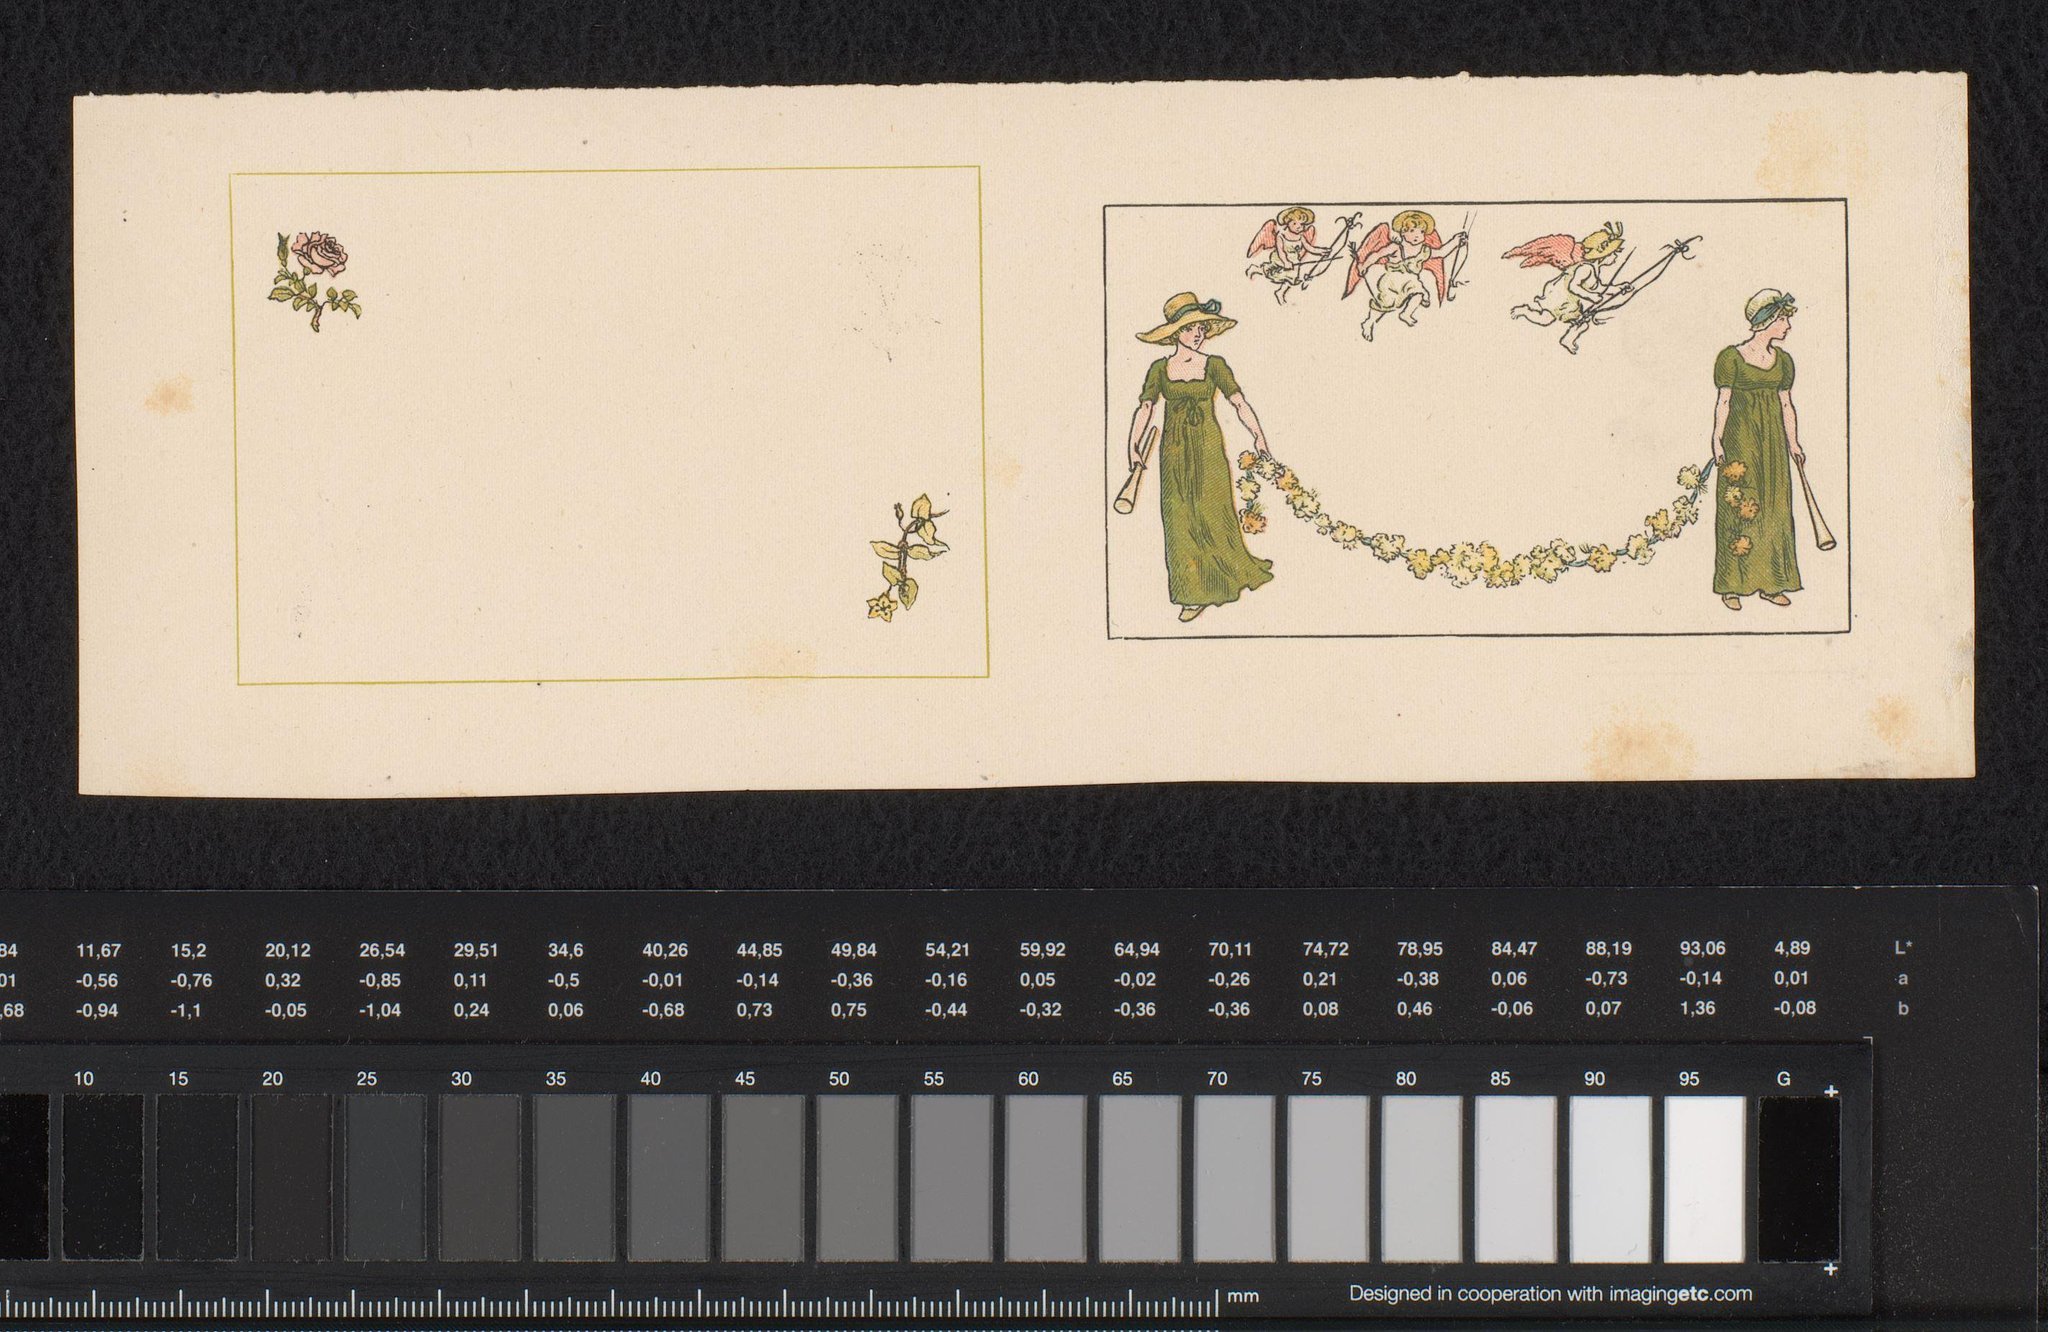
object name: print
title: Vijf proefdrukken voor de Almanack for 1887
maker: Anonymous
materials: paper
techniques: wood engraving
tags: adult woman, garland, wreath, cupids: 'amores', 'amoretti', 'putti'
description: Proefdrukken, vóór de letter, van vier bladzijden uit de almanak: drie met kleine bloemvignetten, en de titelpagina (met daarop drie putti vliegend boven twee vrouwen met een bloemslinger).